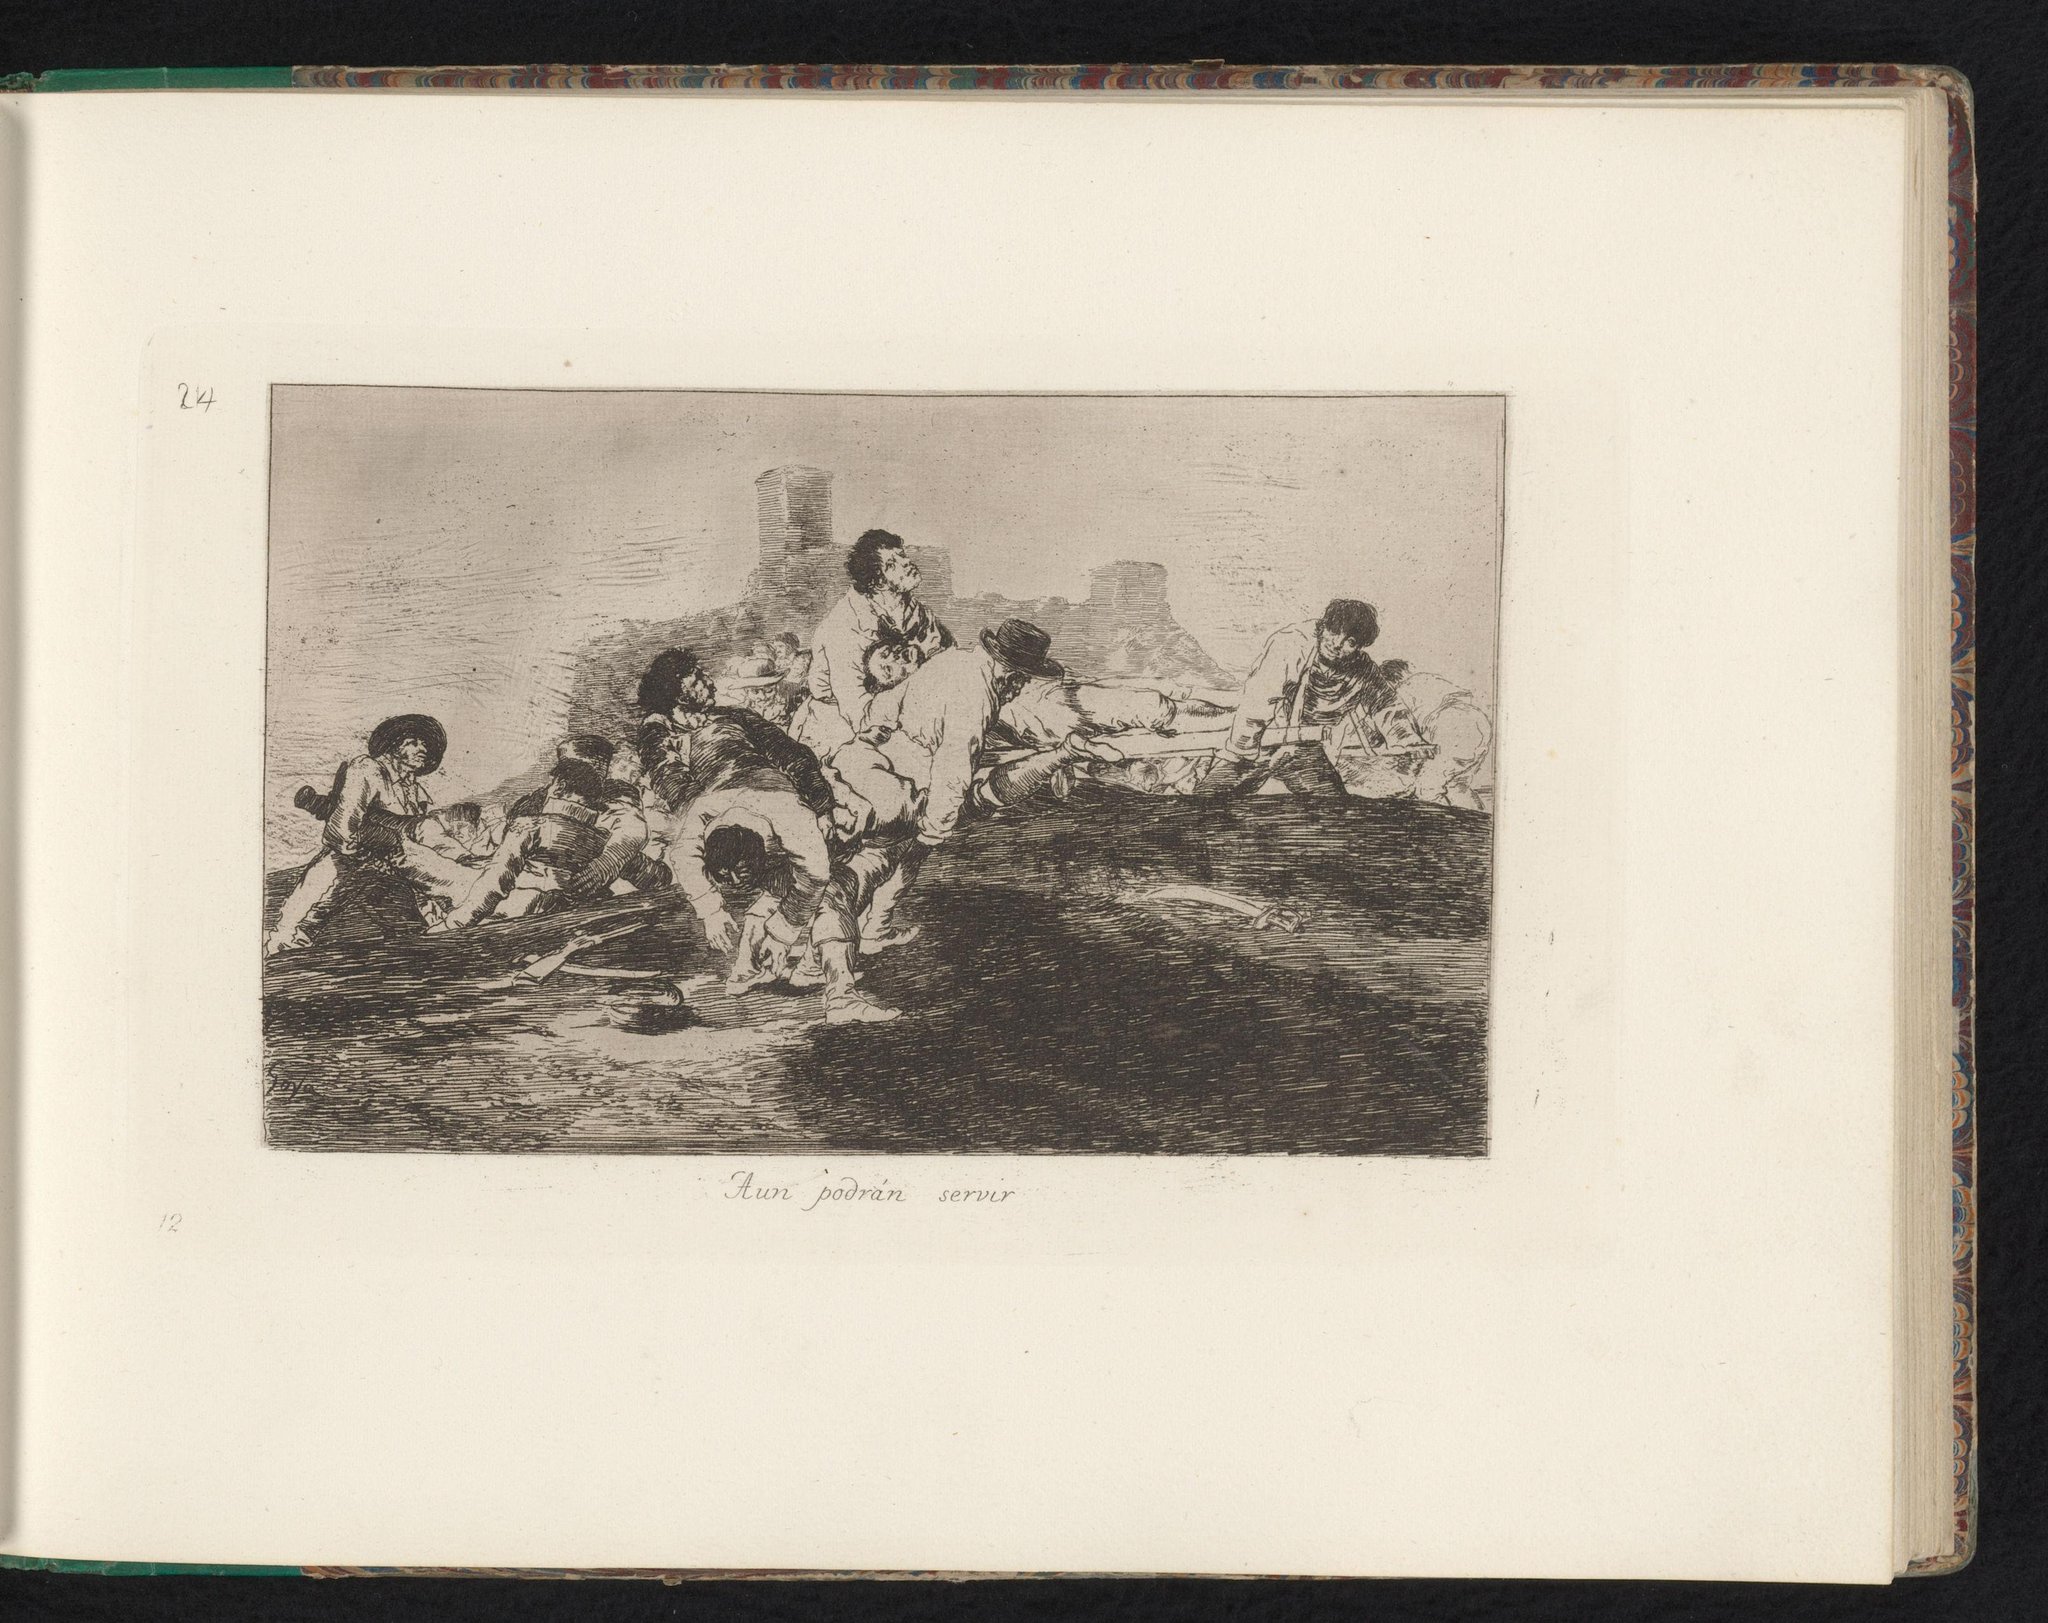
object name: print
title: Aun podrán servir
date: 1810-1820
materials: paper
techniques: etching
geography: madrid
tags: carrying the sick, wounded and dead off the battle-field, horrors of war, spain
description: Deze prent maakt deel uit van een album.